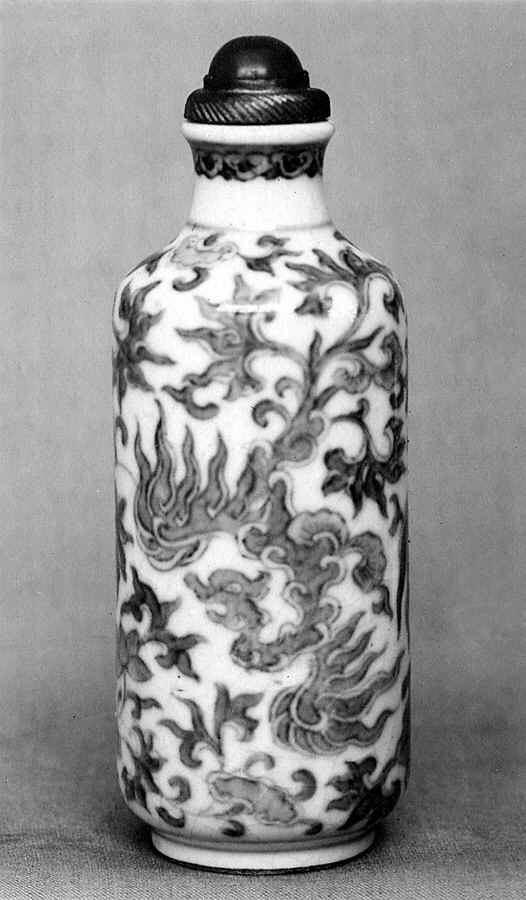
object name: snuff bottle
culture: chinese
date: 1801-1900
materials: soft paste porcelain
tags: mythical creatures